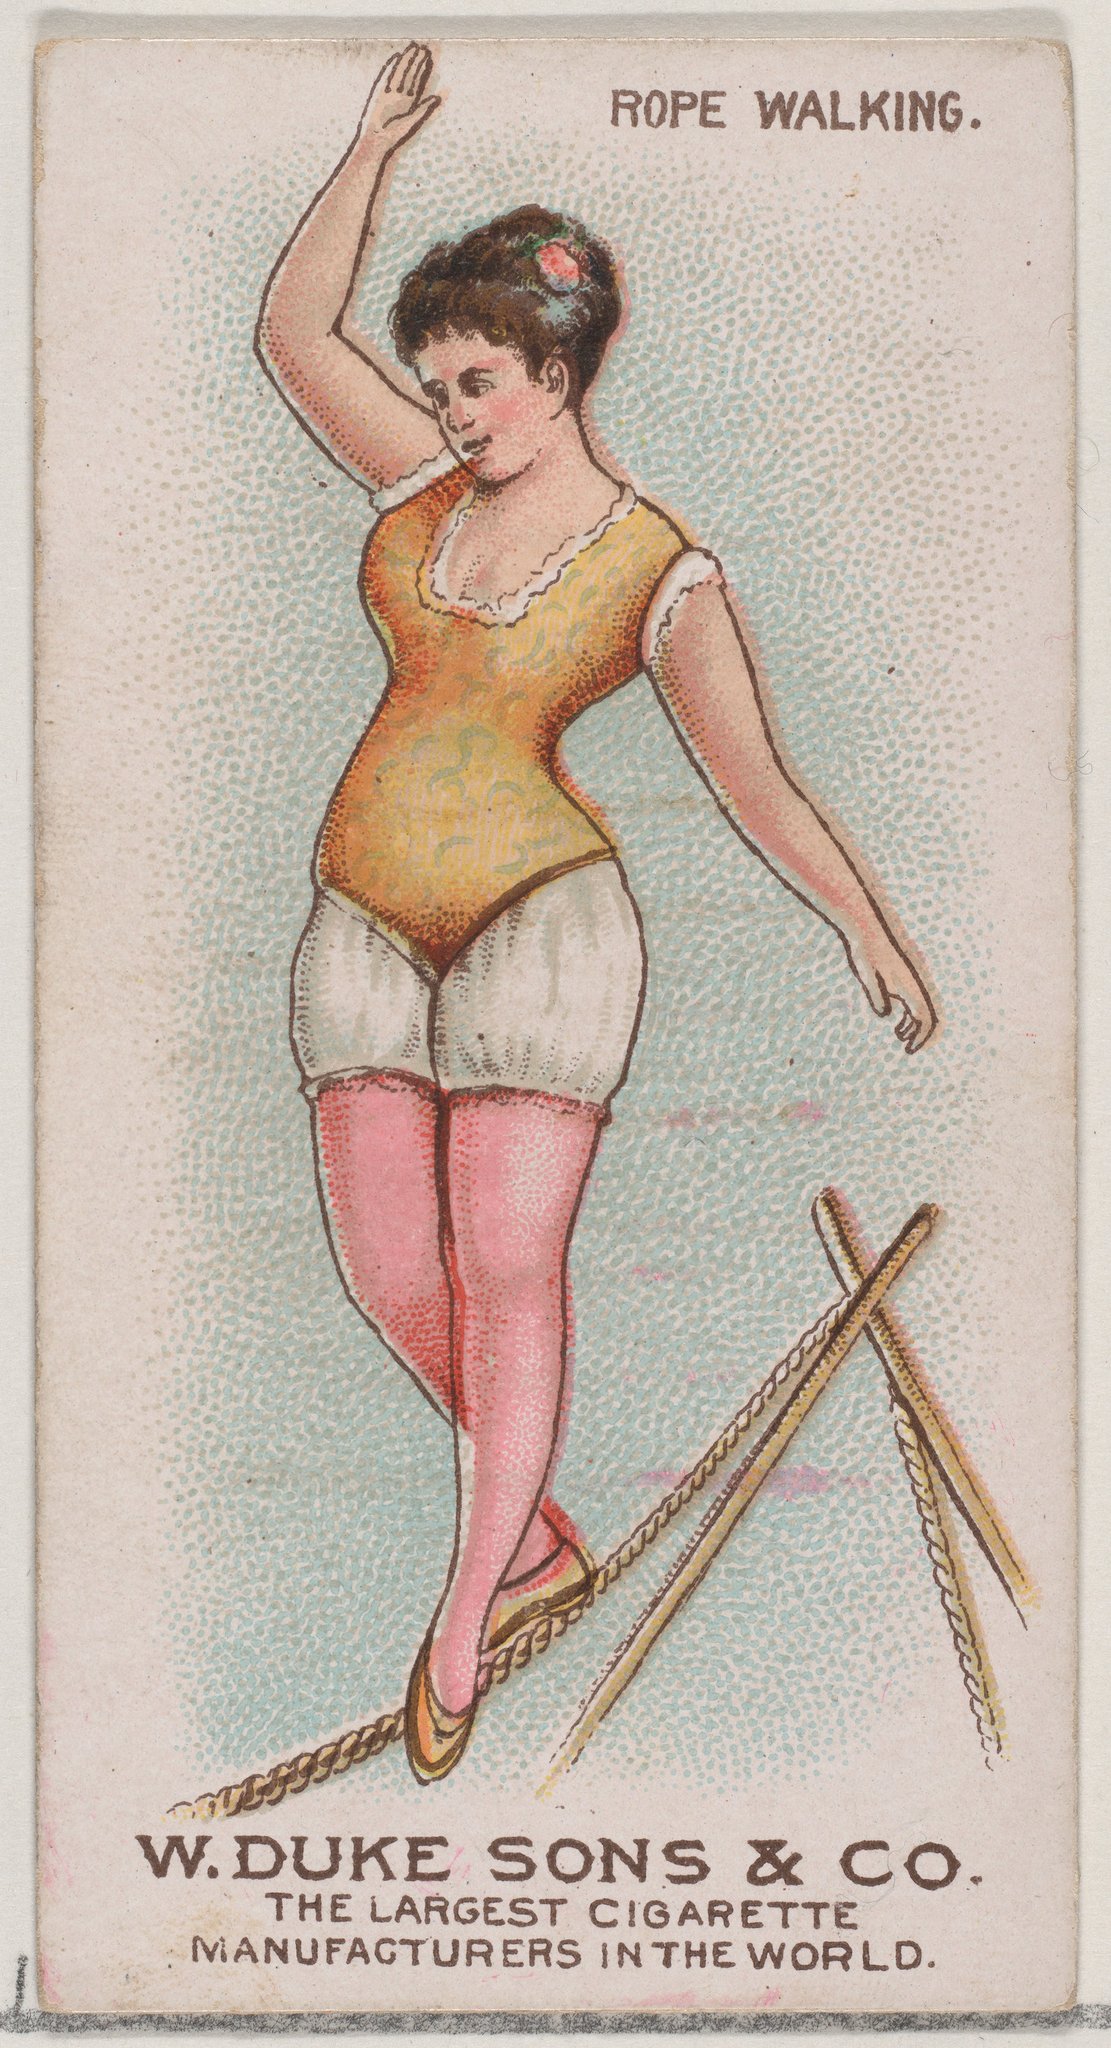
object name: print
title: Rope Walking, from the Gymnastic Exercises series (N77) for Duke brand cigarettes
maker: w. duke, sons & co.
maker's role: publisher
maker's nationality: american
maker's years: 1870-1920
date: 1887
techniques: color lithograph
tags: women,sports,athletes